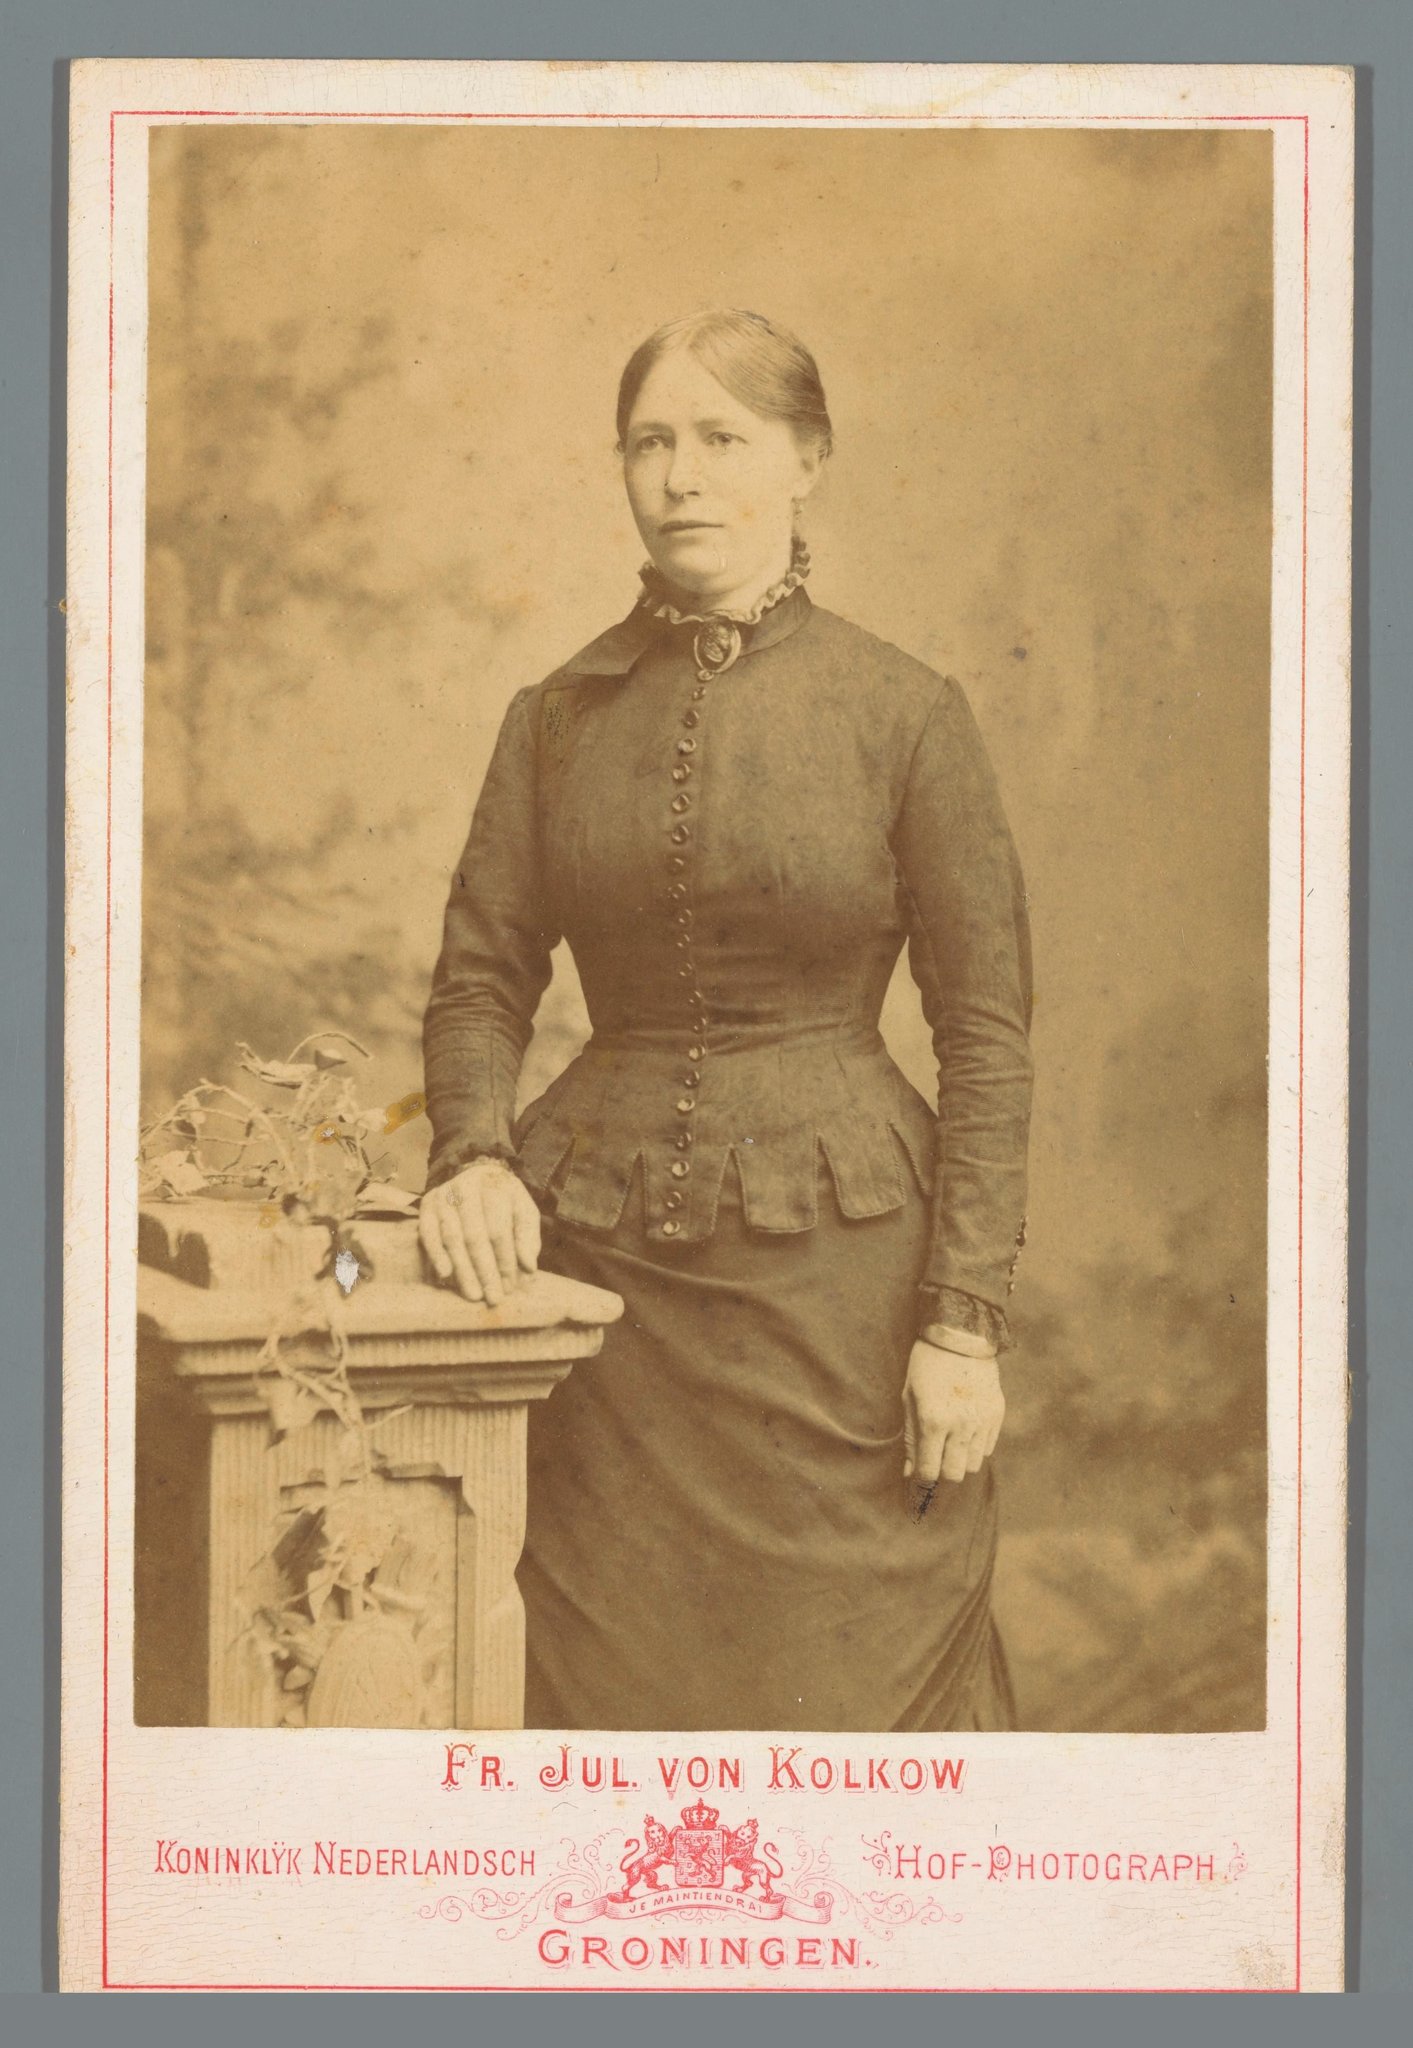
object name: cabinet photograph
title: Portret van een onbekende vrouw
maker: friedrich julius von kolkow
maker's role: fotograaf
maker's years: 1839-1914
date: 1864-1913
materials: cardboard, photographic support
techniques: albumen print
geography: groningen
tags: adult woman, studio requisites ~ photographer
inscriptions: name: ‘Fr. Jul. von Kolkow Koninklijk Nederlandsch Hof-Photograph Groningen.’